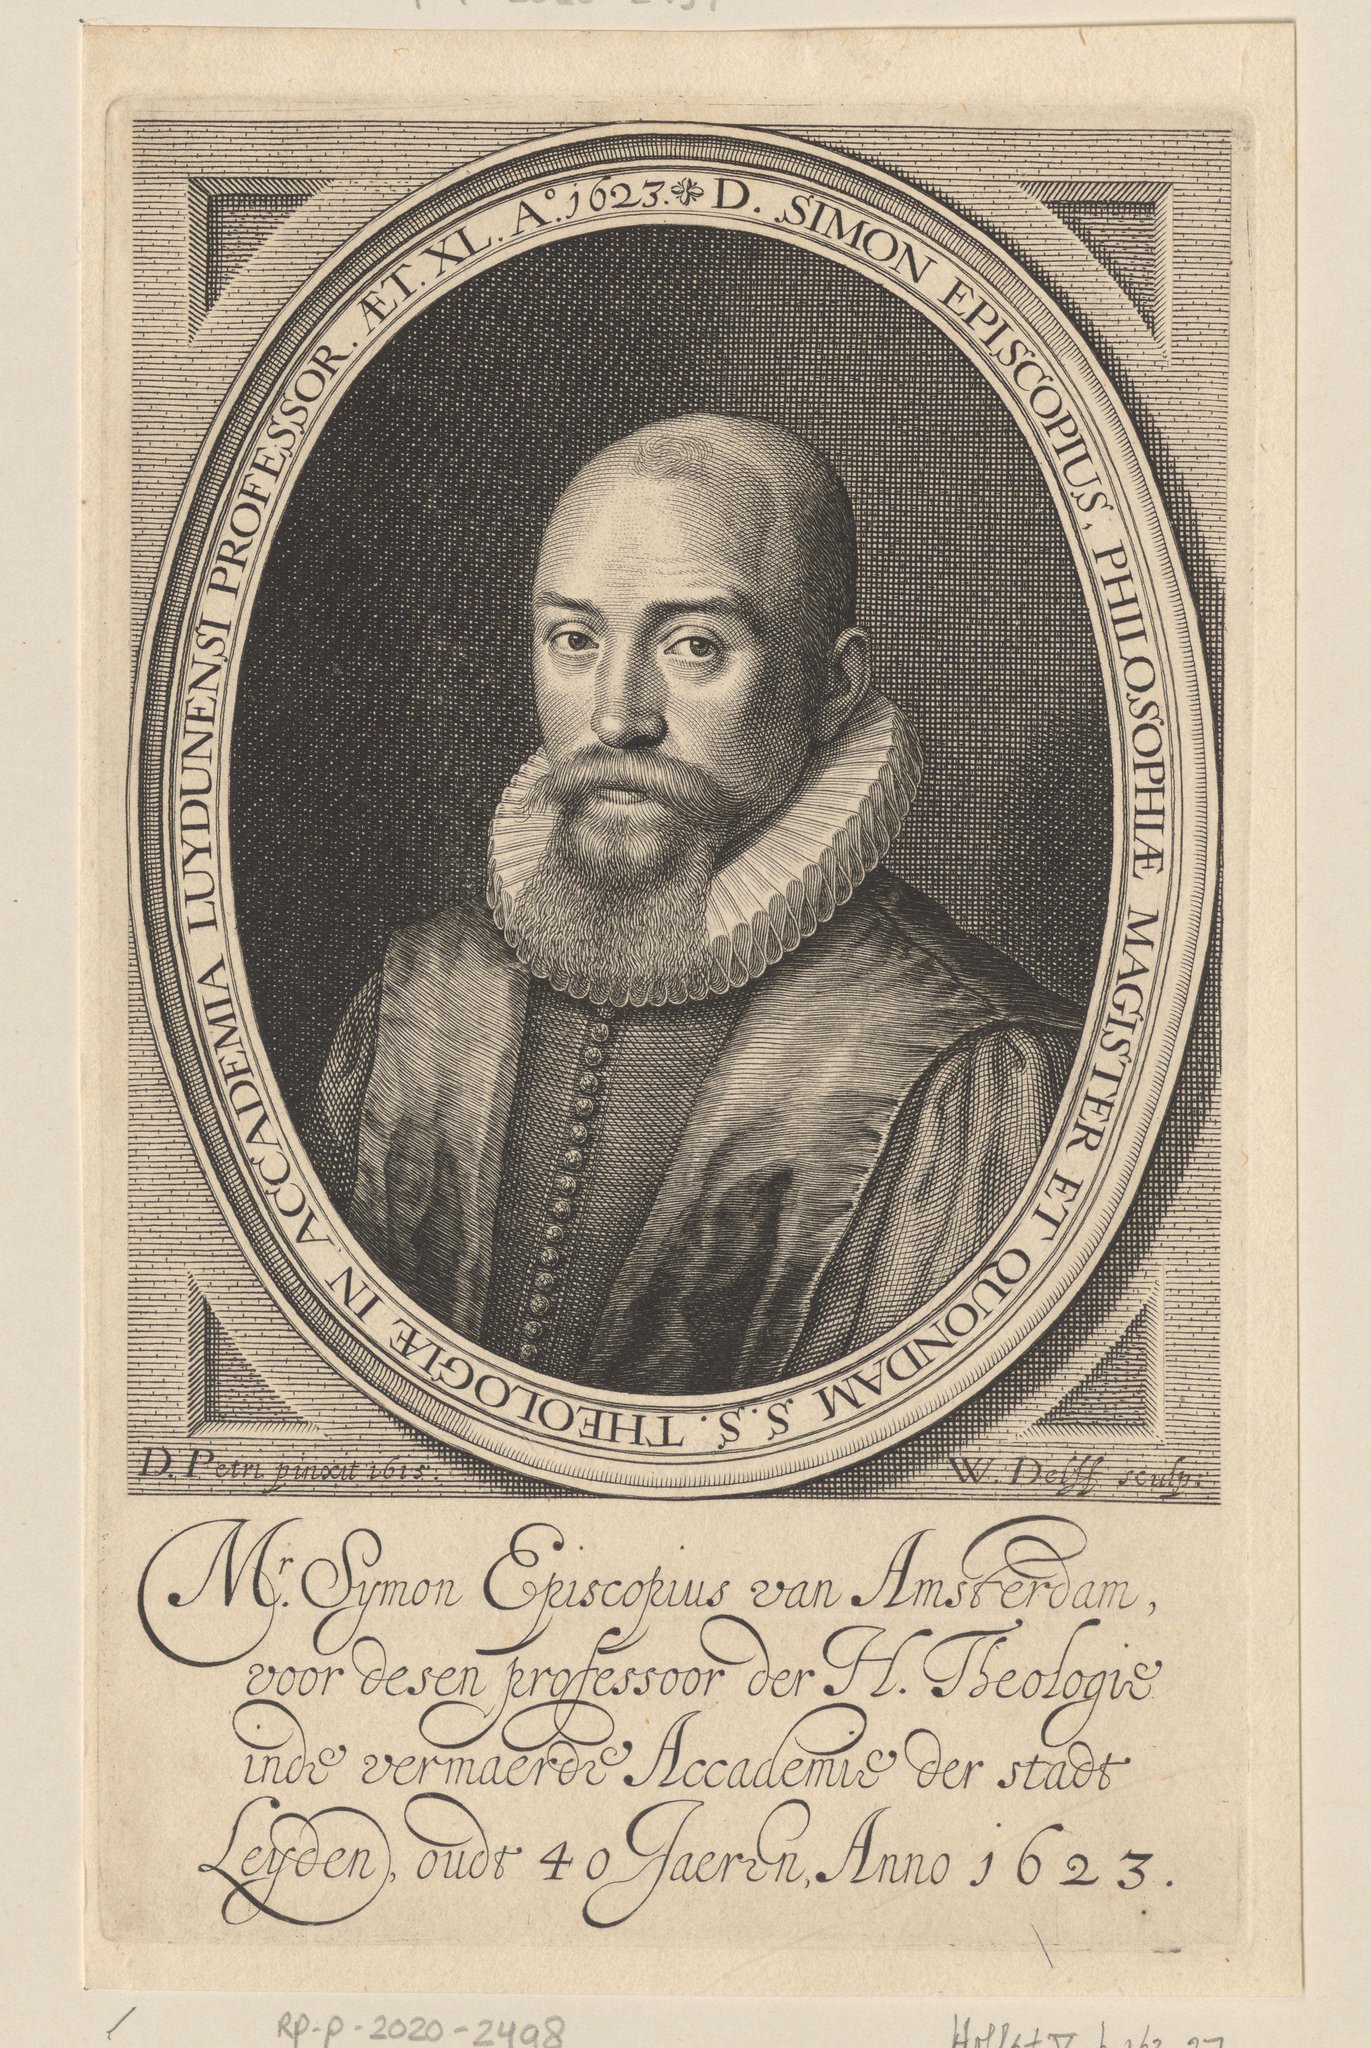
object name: print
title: Portret van Simon Episcopius op 40-jarige leeftijd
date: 1623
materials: paper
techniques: engraving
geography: delft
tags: amsterdam, theologian, historical persons, professor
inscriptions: date